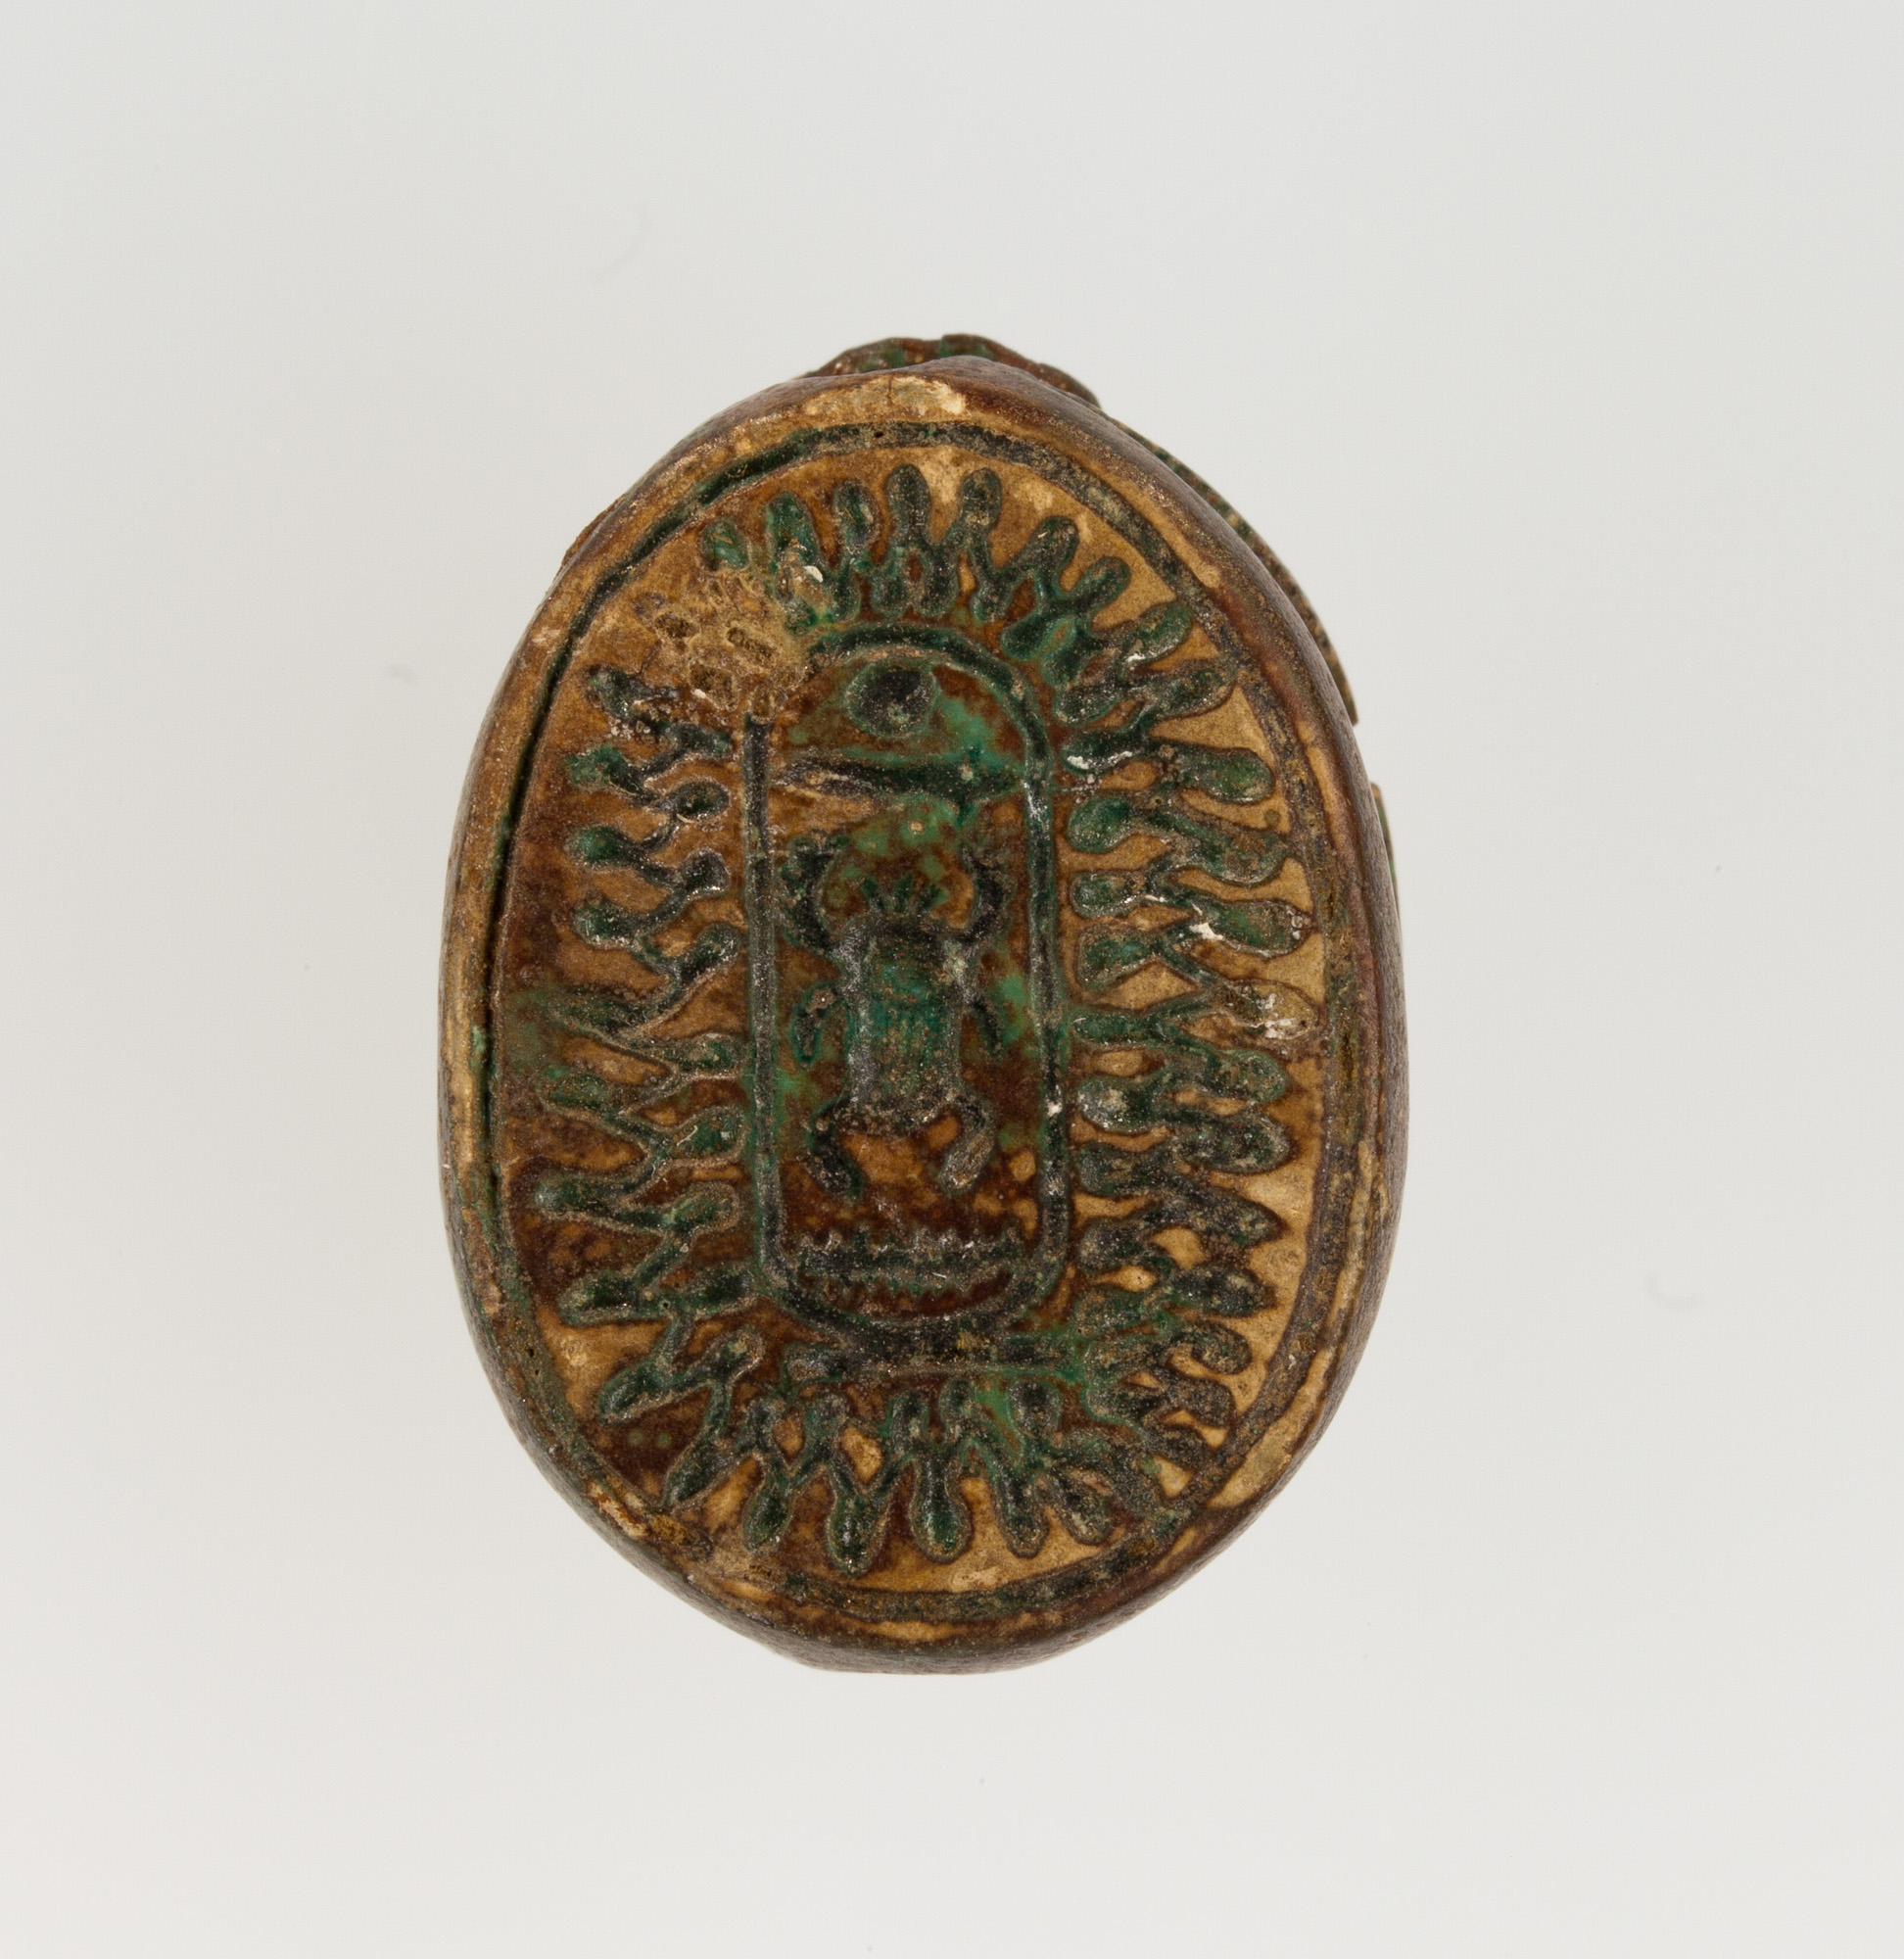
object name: scarab, thutmose i, aakheperkare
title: Scarab Inscribed with the Throne Name of Thutmose I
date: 1504-1492 BCE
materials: stone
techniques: glazing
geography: egypt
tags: hieroglyphs,scarabs